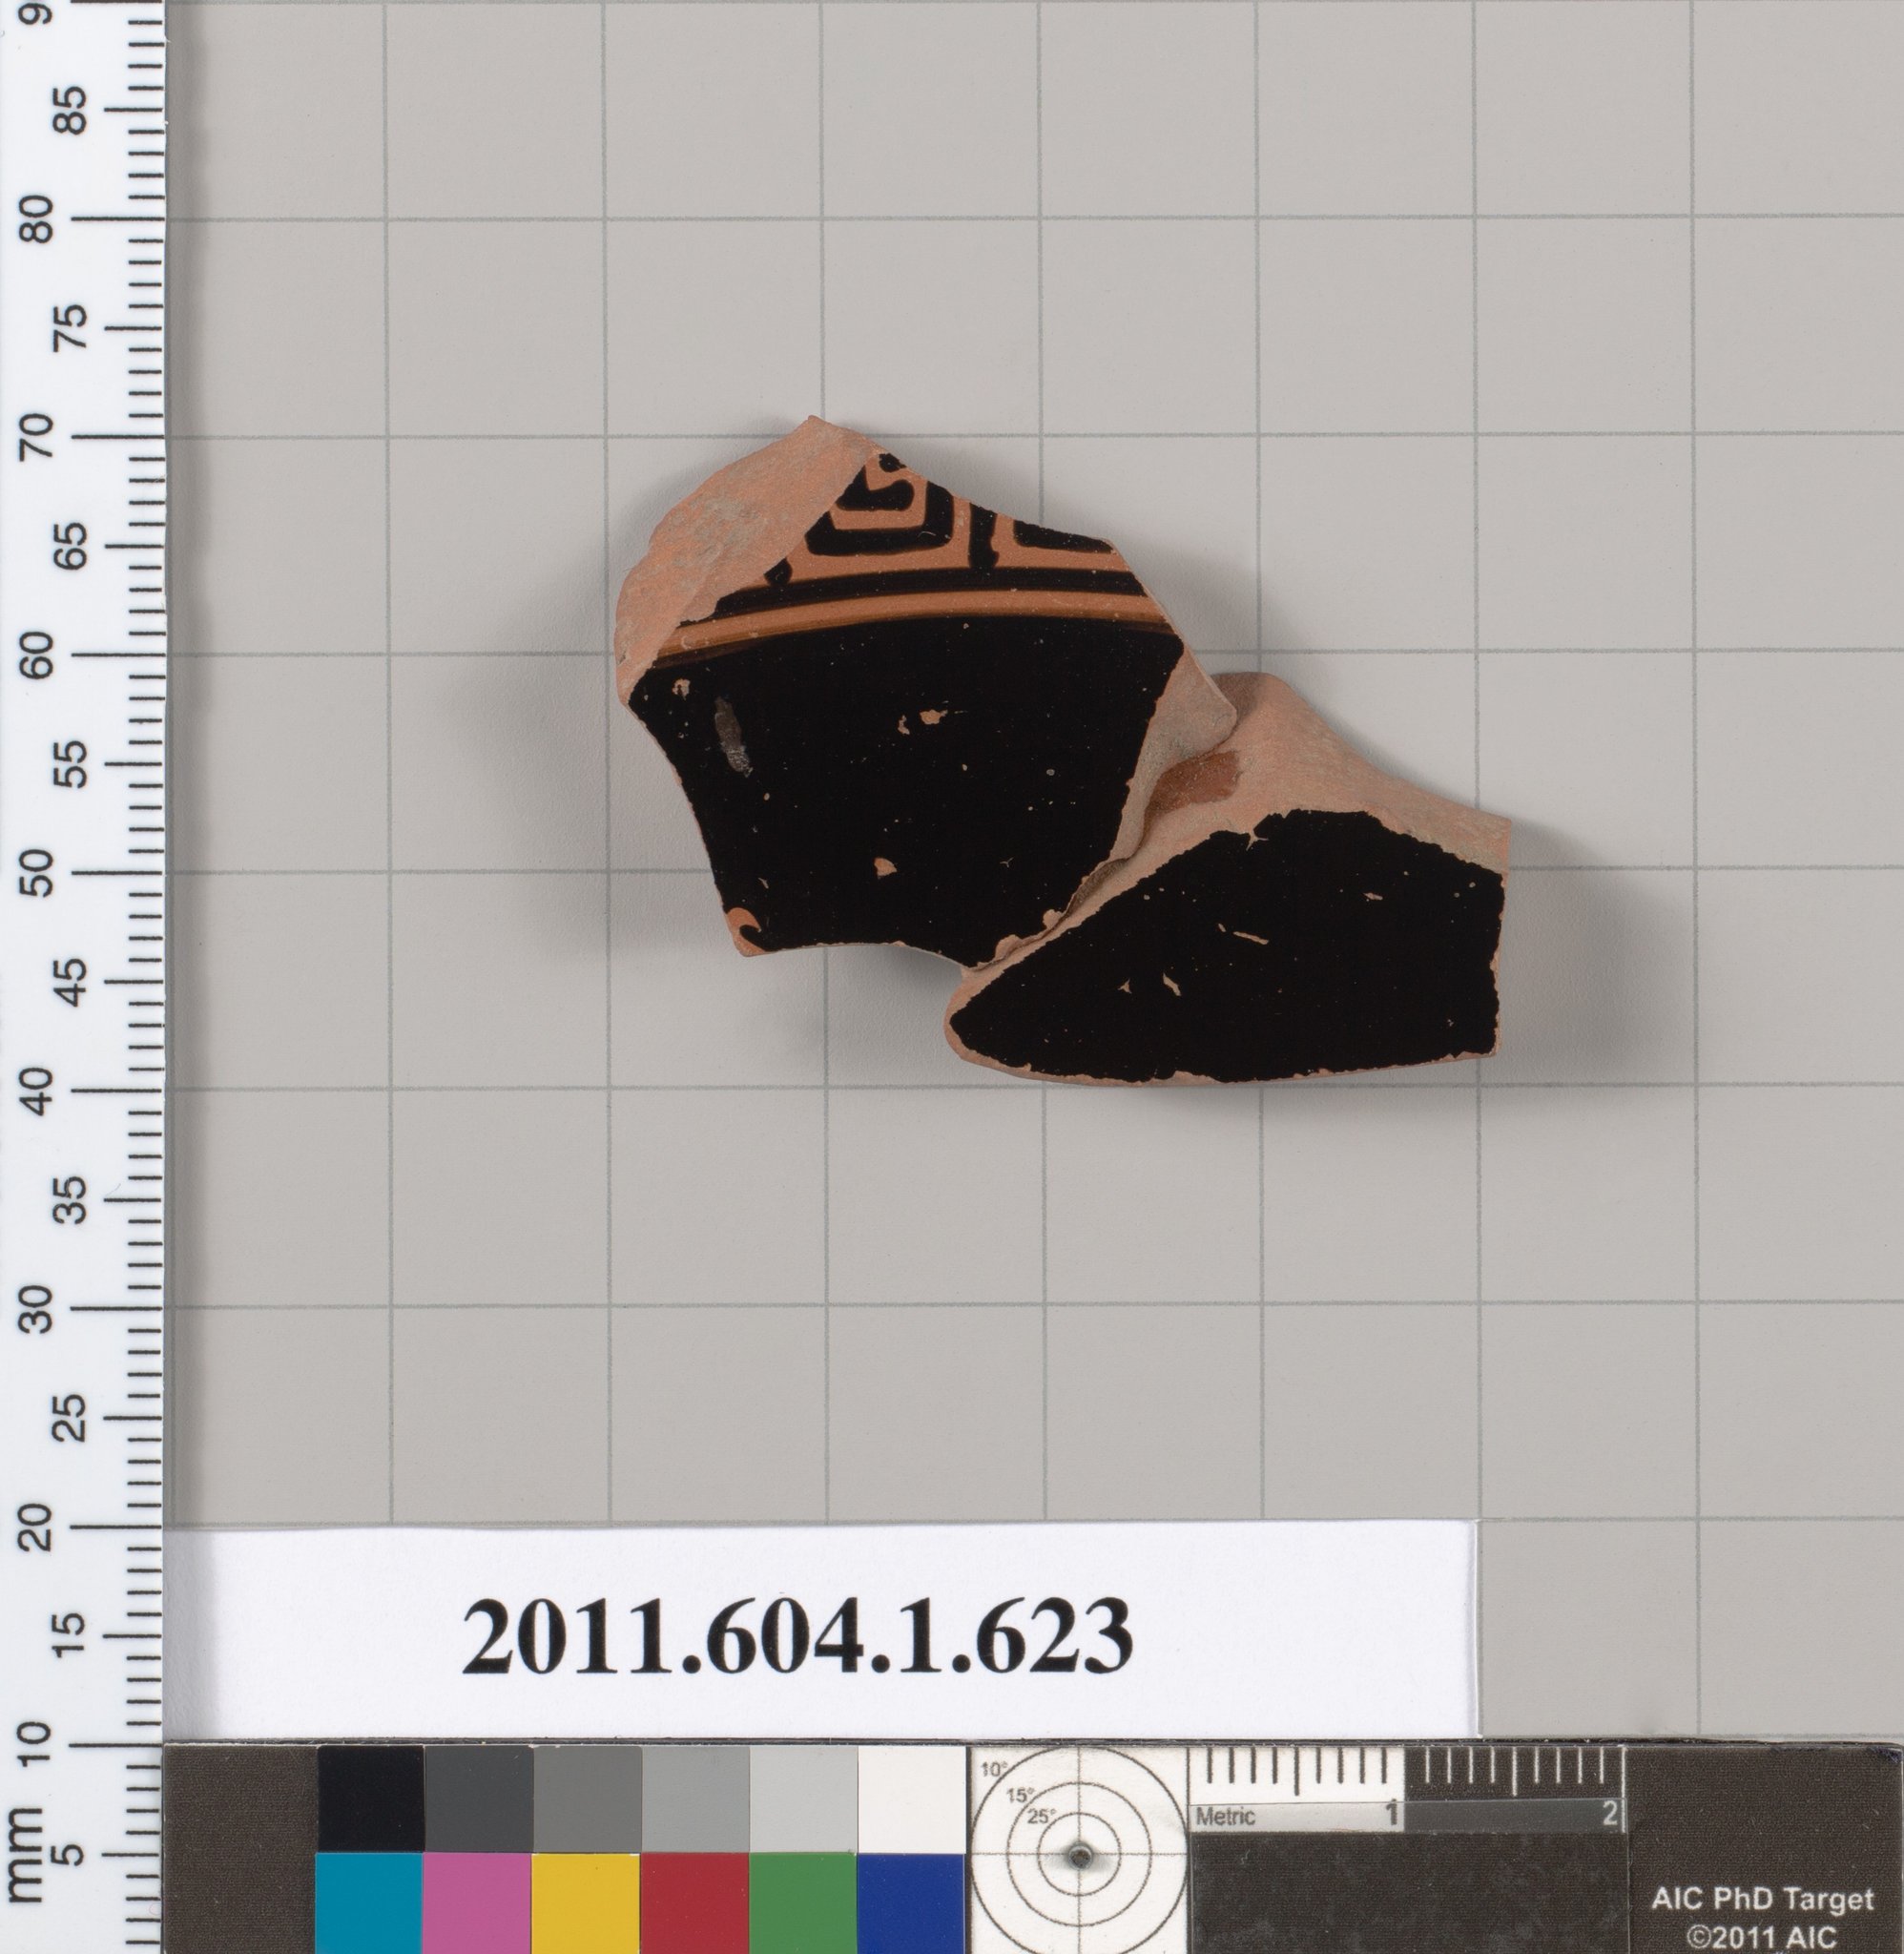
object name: kylix fragment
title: Terracotta fragment of a kylix (drinking cup)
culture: greek, attic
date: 475-451 BCE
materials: terracotta